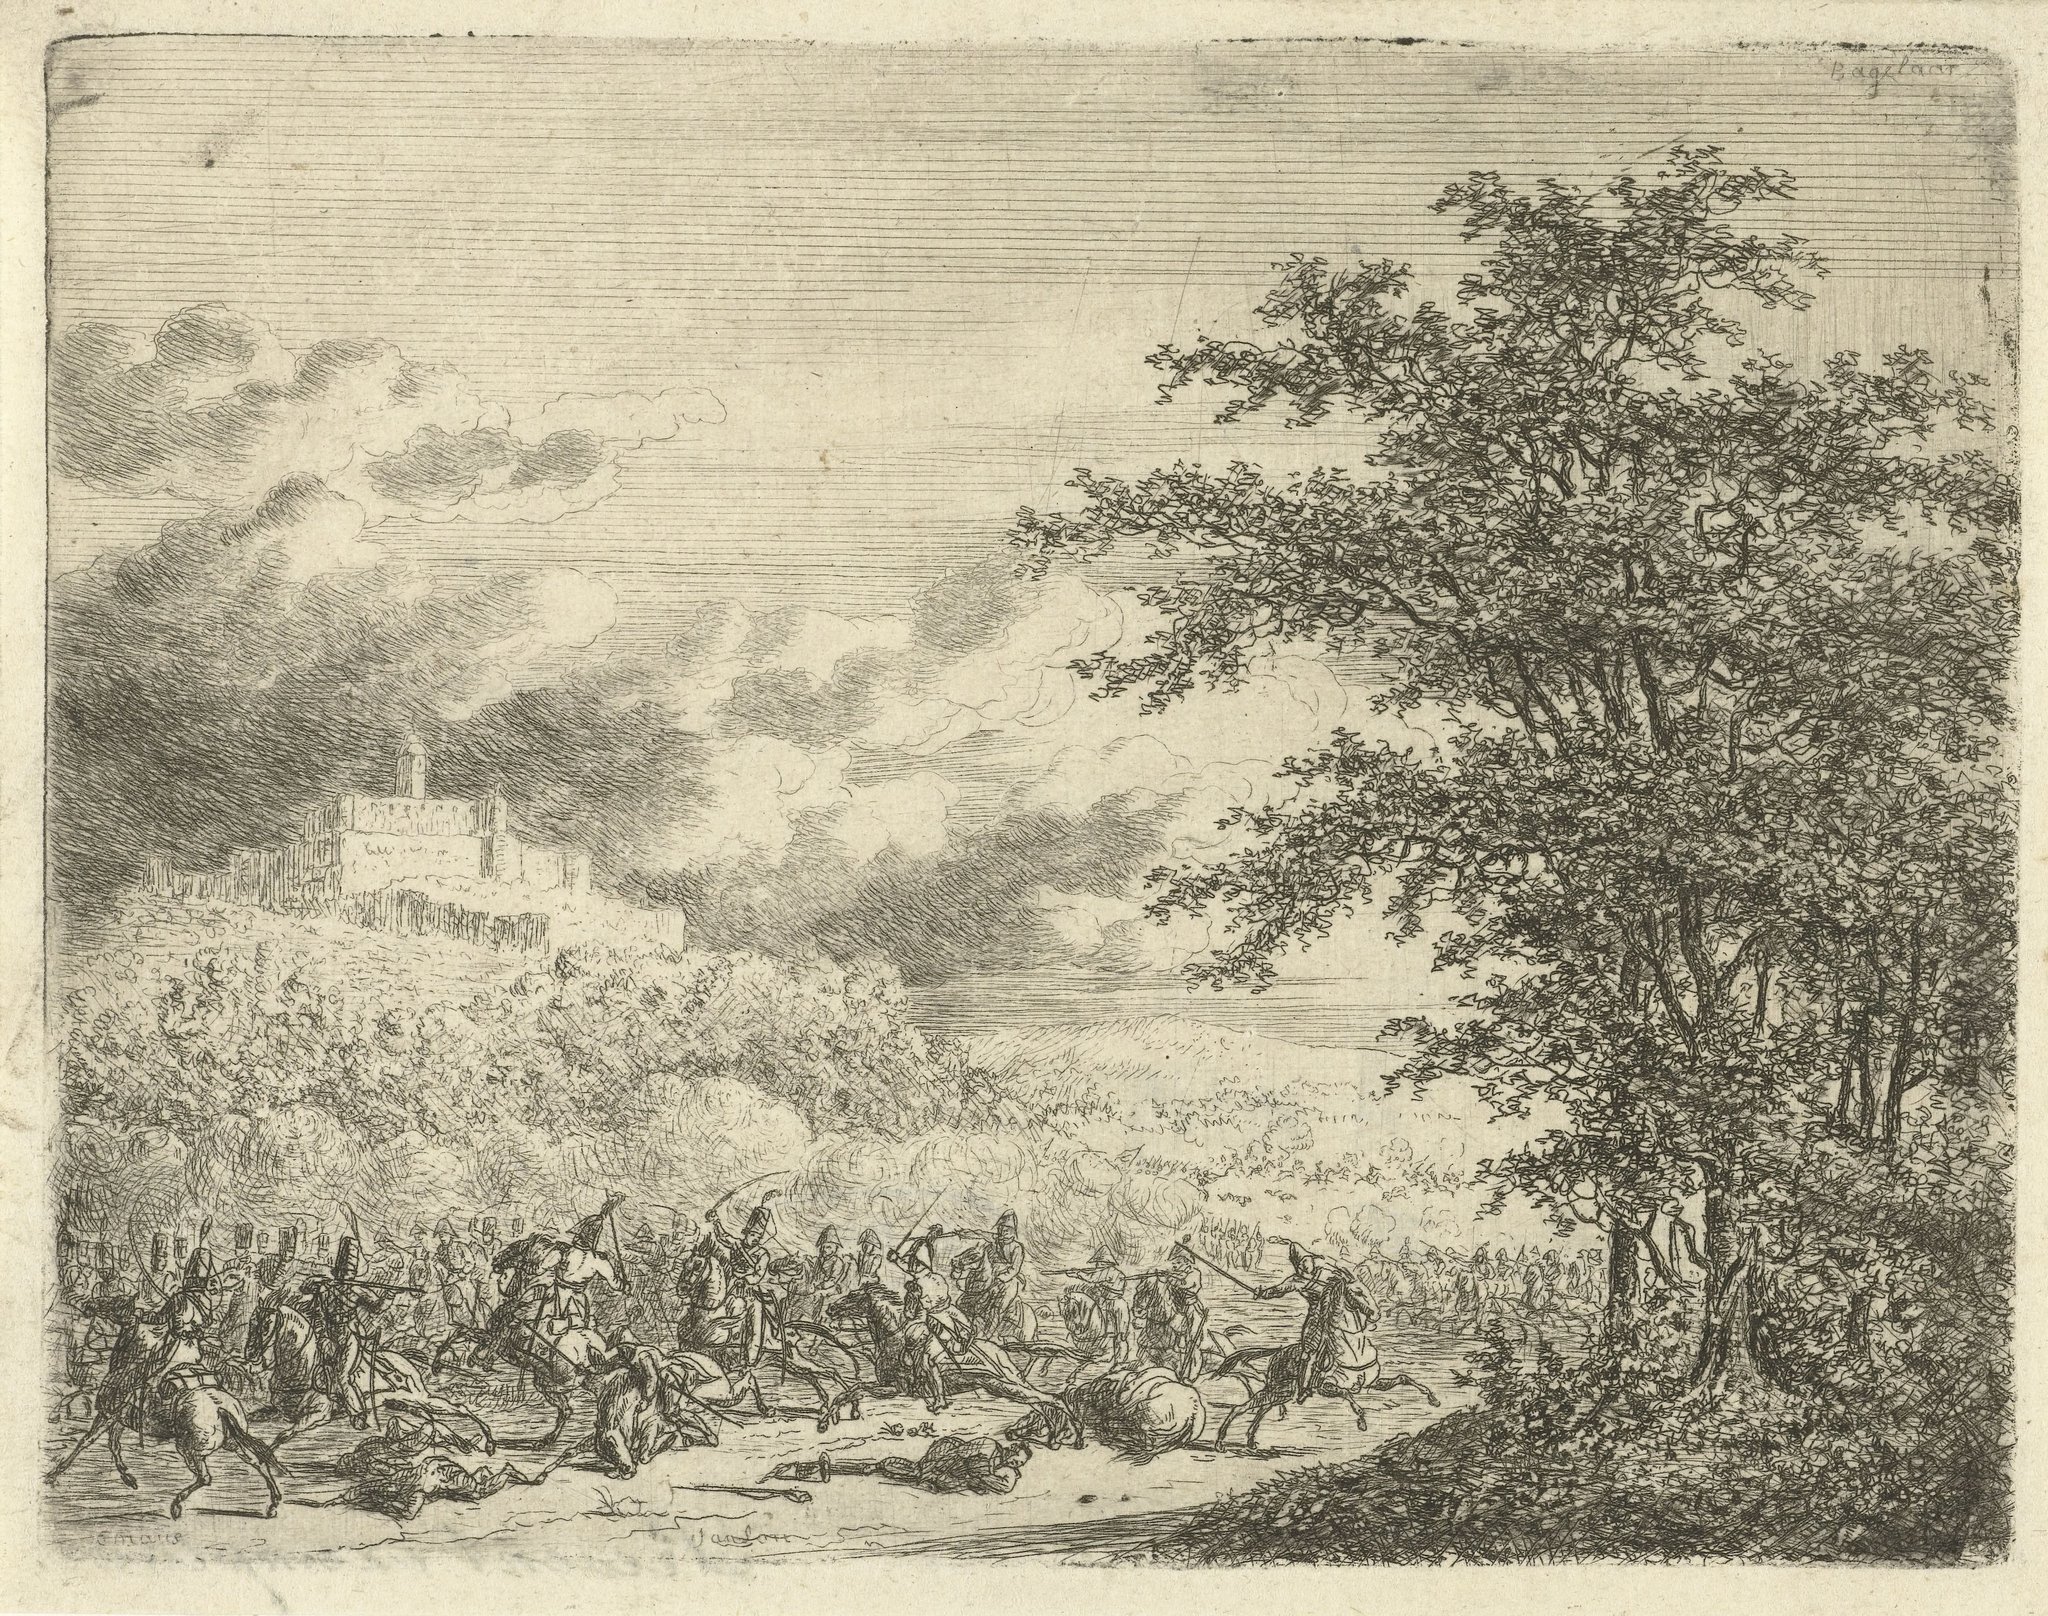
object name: print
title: Het treffen bij Königstein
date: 1813-1863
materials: paper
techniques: etching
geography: netherlands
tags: warfare; military affairs (+ cavalry, horsemen)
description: Op een vlakte met boompartij vindt een veldslag met cavaleristen plaats. Op een heuvel op de achtergrond het fort Königstein.